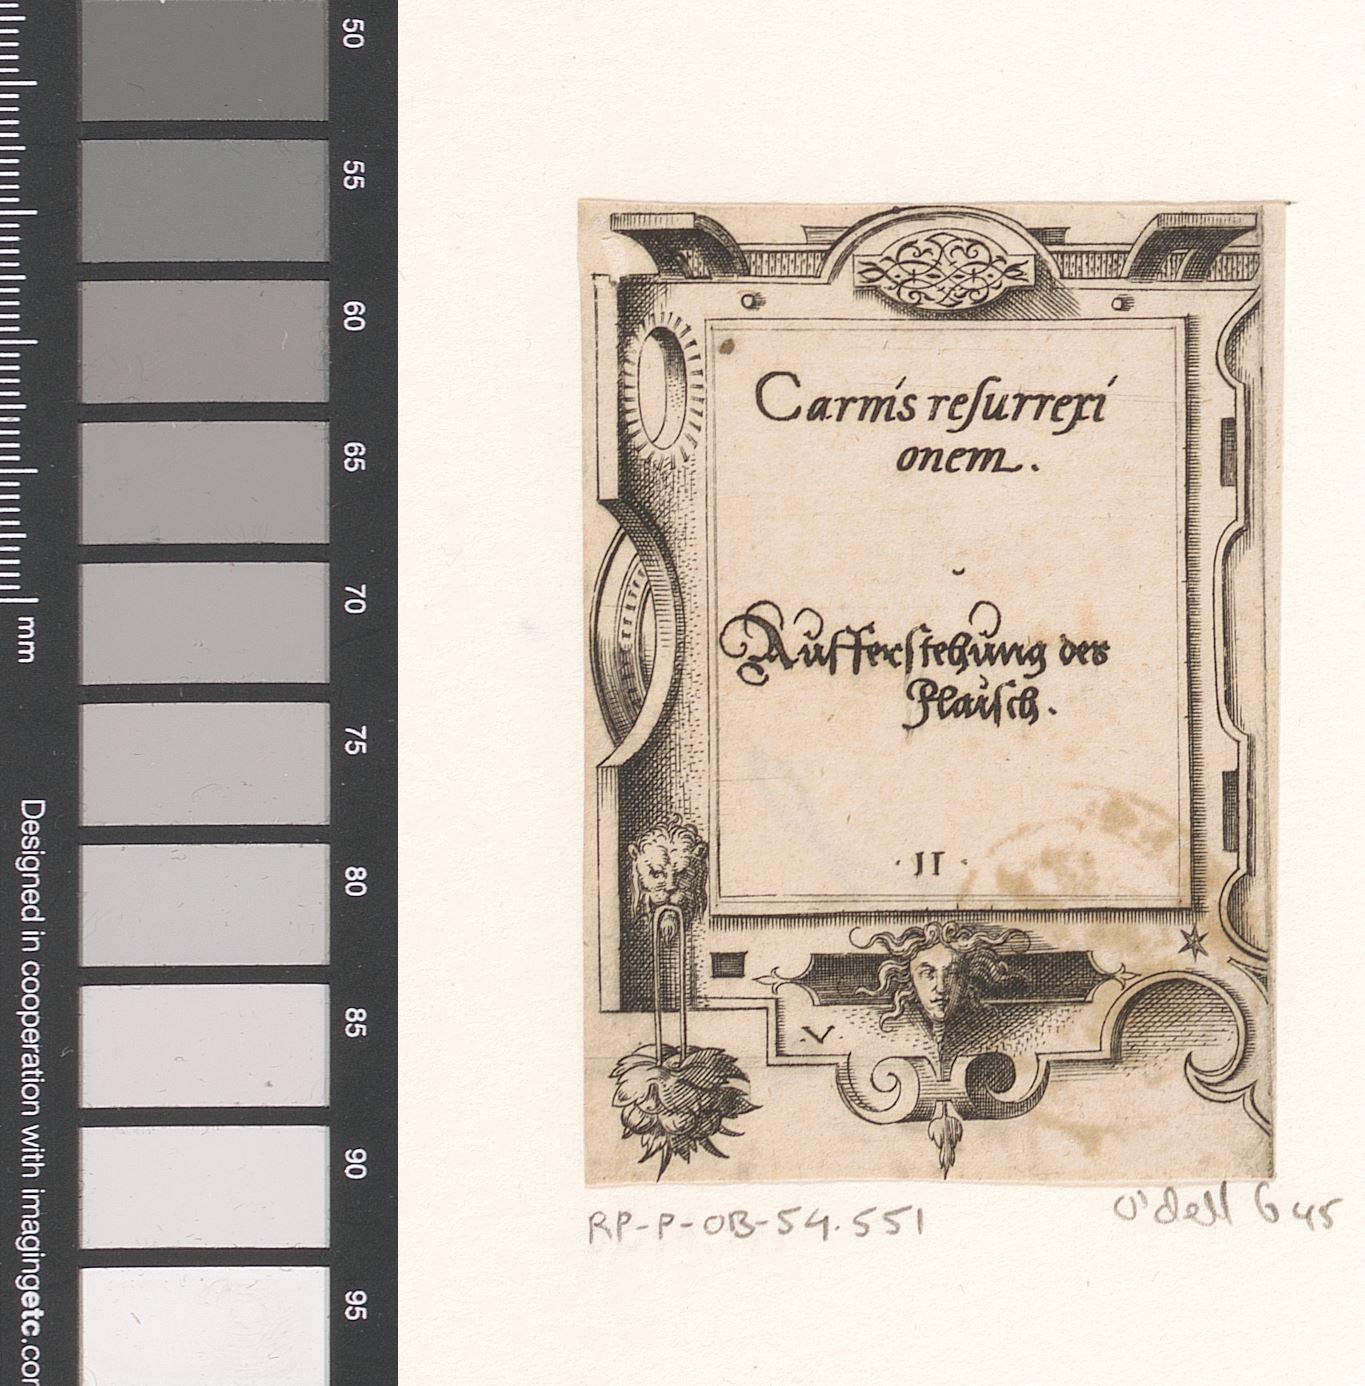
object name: print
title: Gebed in Latijn en Duits in een rolwerk omlijsting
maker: virgilius solis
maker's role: draughtsman, print maker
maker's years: 1514-1562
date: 1568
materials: paper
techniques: engraving, etching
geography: nuremberg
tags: scrollwork, strapwork ~ ornament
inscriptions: collector's mark: Lugt 240, collector's mark: Lugt 2228, number: ‘87’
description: Prent gebruikt voor het gebedenboek: Solis, Virgil. Ein New Künstlich Betbüchlein. Neurenberg: Hieronymus Petri, 1568. Bij elke prent met afbeelding van een apostel behoort een prent met een gebed in het Latijn en in het Duits. Bij elkaar horende prenten hebben dezelfde nummering en het monogram VS is steeds verspreid over twee bladen met dezelfde nummering.